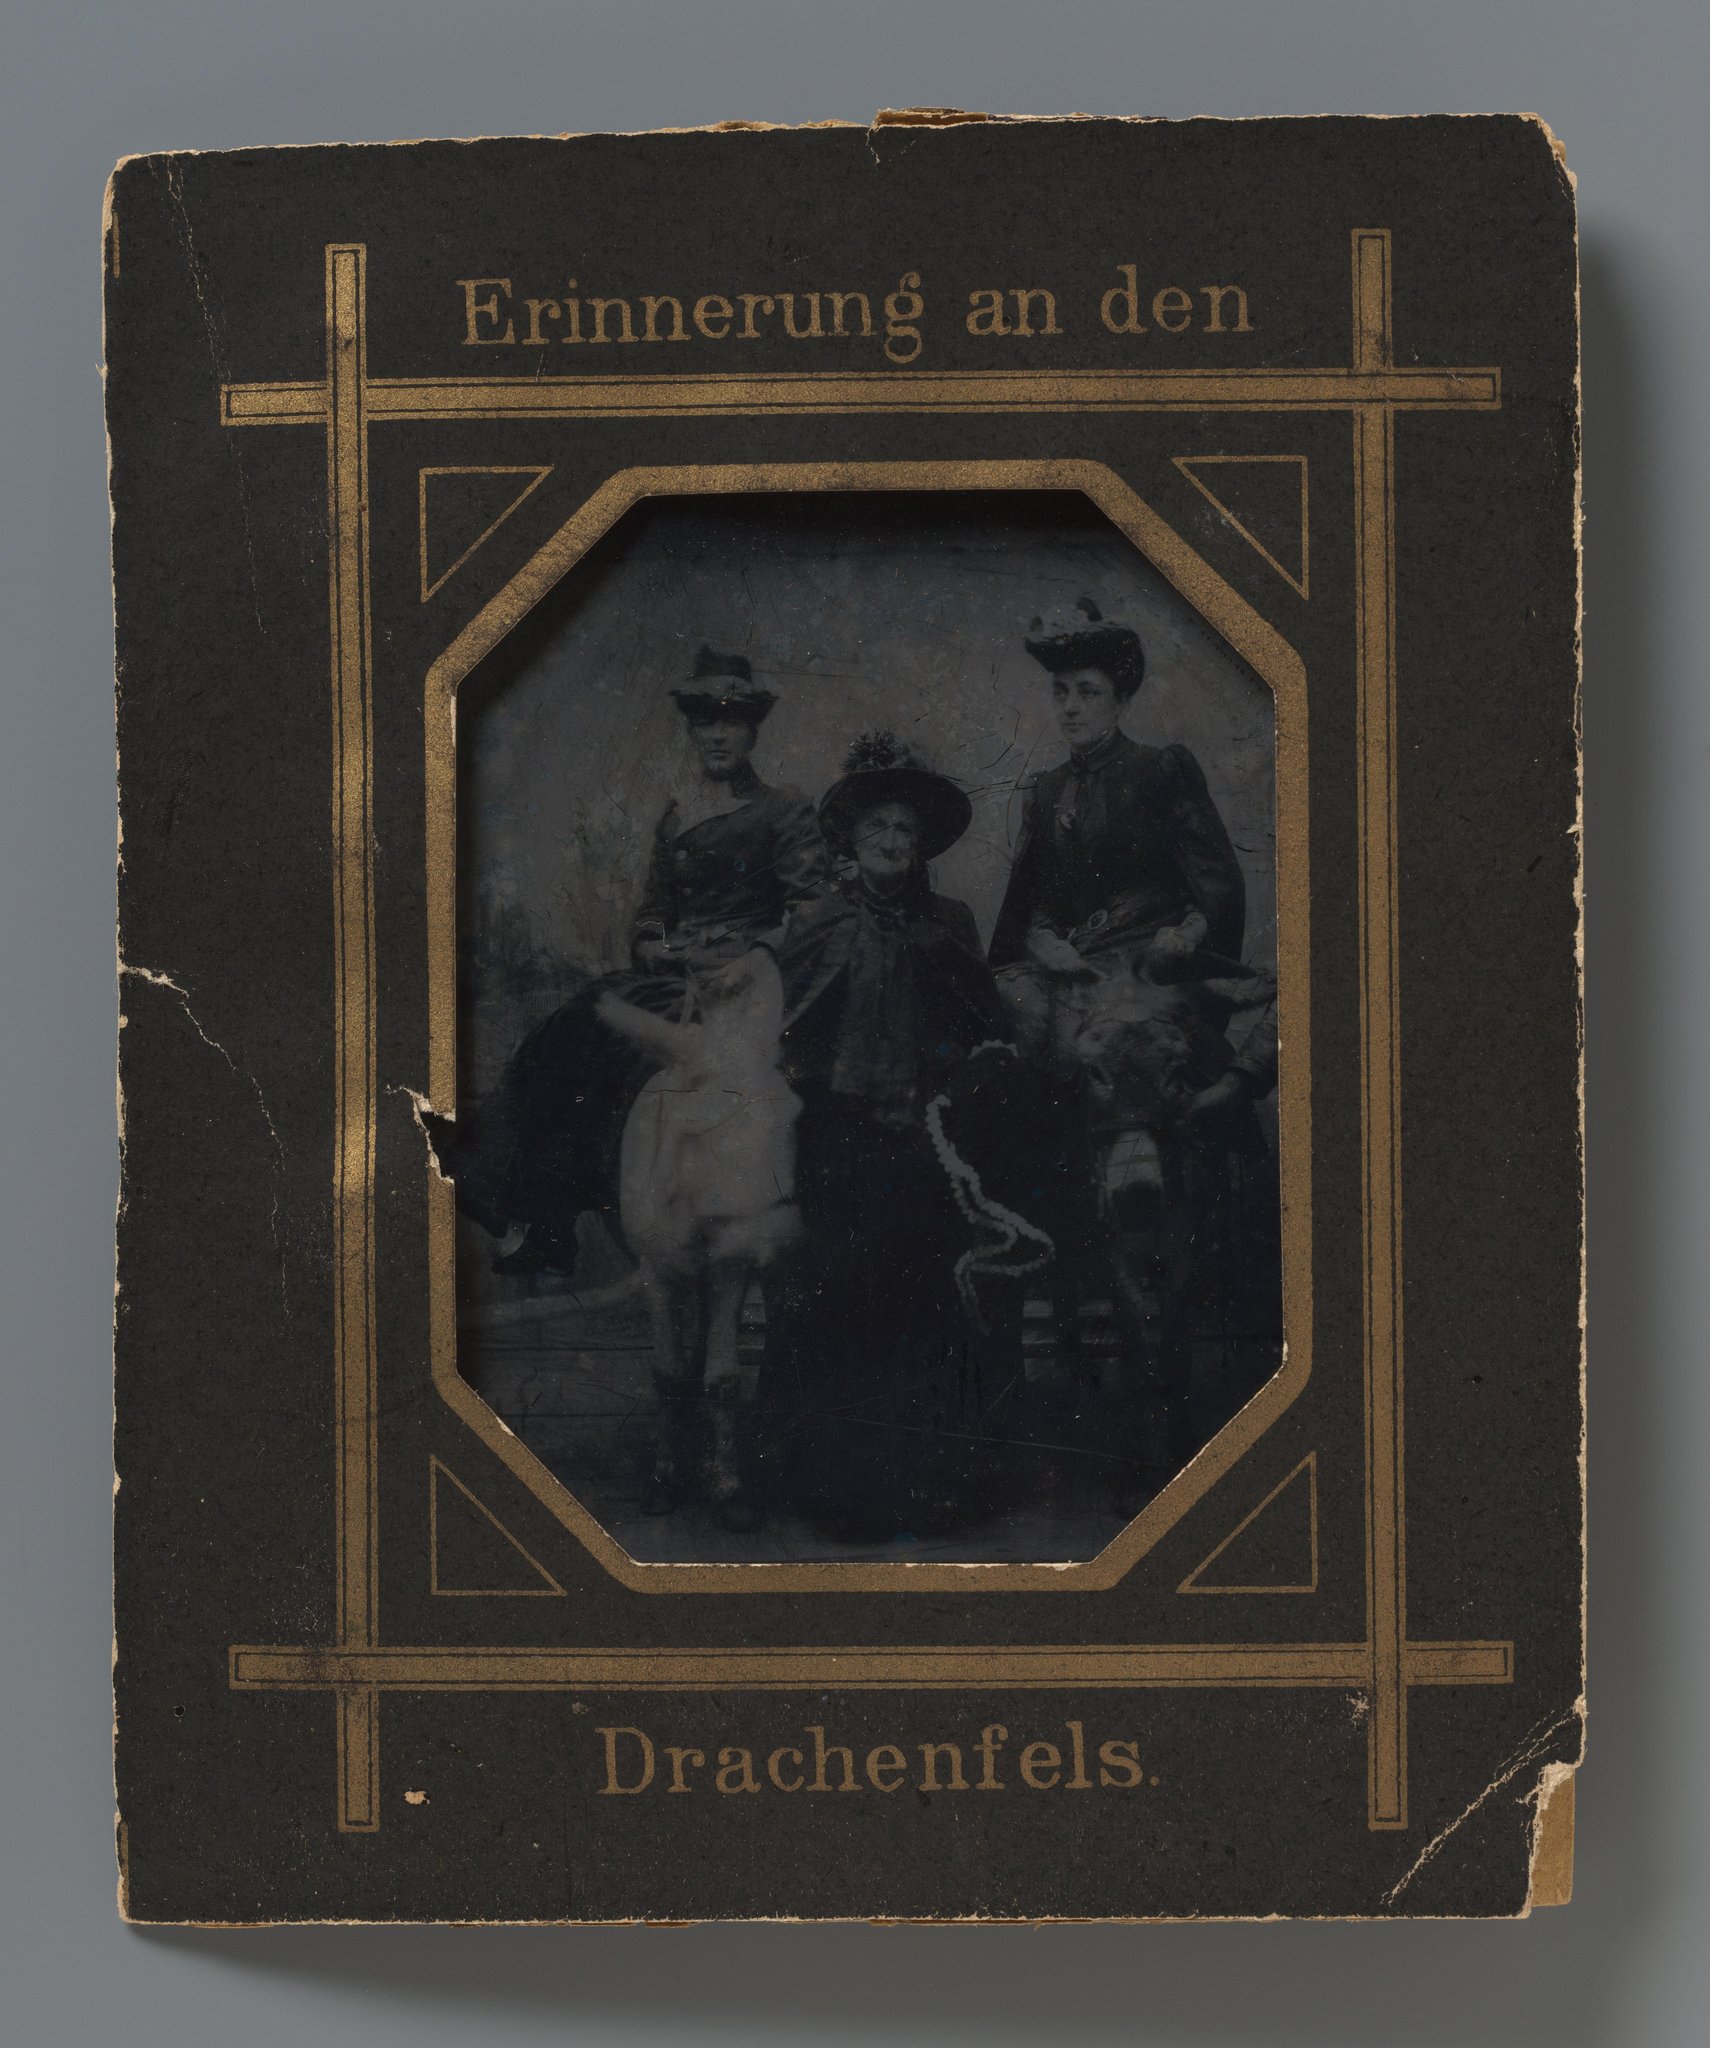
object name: photograph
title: Groepsportret van drie onbekende vrouwen, twee zitten op ezels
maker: Anonymous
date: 1855-1875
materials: cardboard, glass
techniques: ambrotype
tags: ass, donkey, anonymous historical persons portrayed in a group, in a group-portrait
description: Bij de glasplaat zit een passe-partout met de tekst: Erinnerung an den Drachenfels.